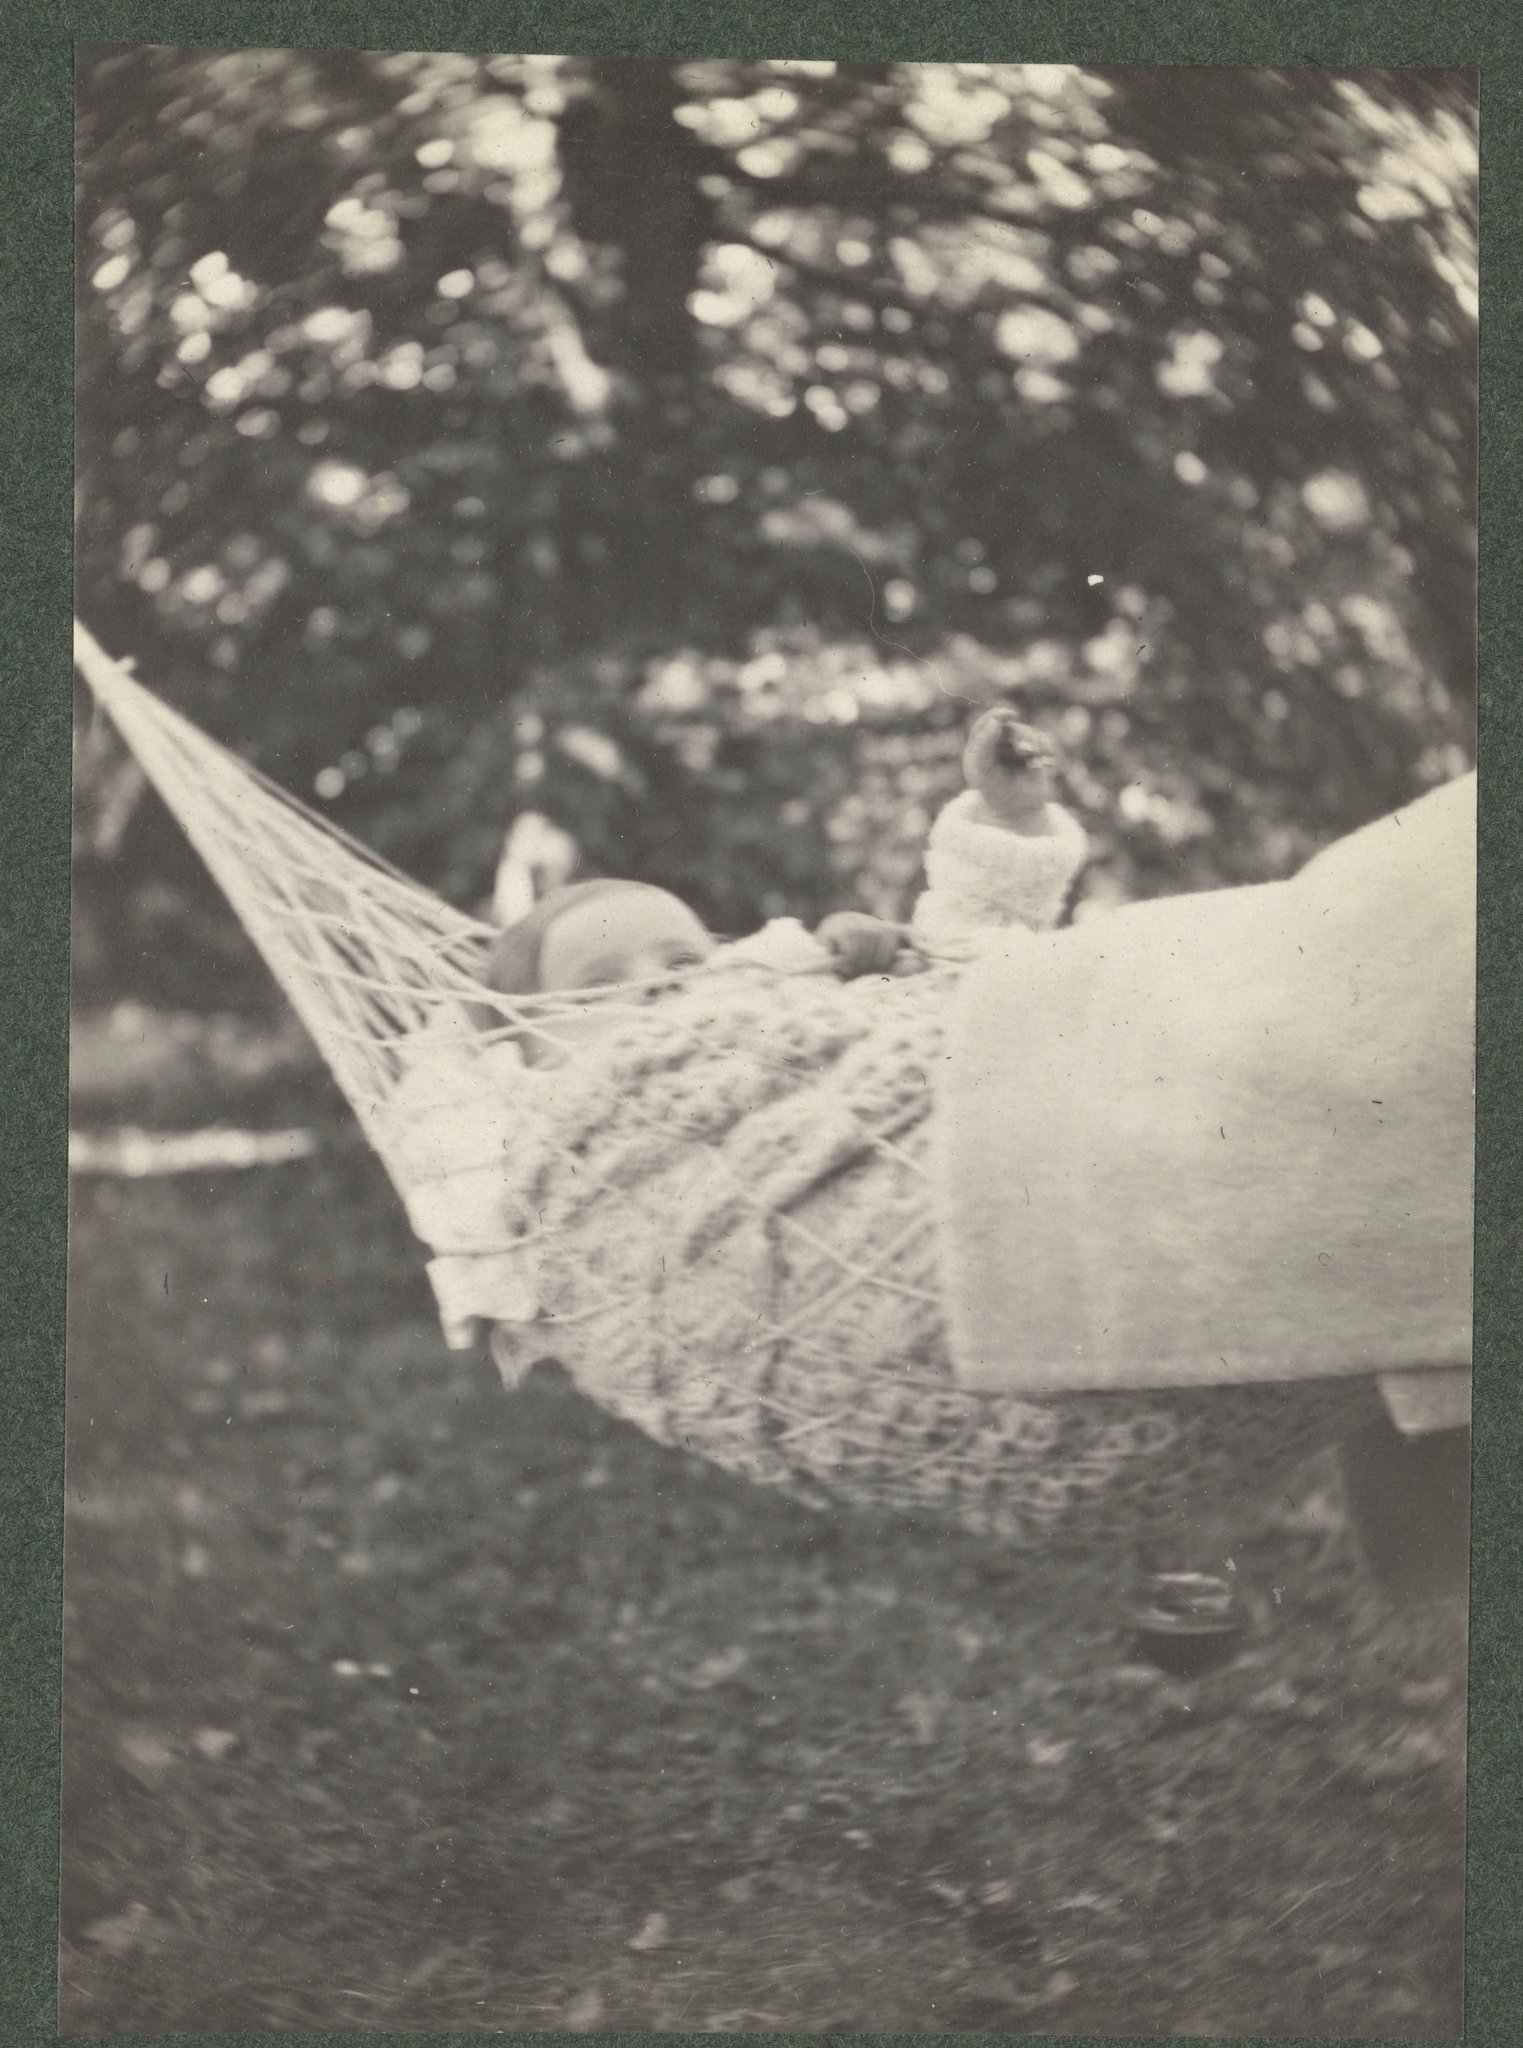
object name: photograph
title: Baby in een hangmat gewikkeld in een deken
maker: geldolph adriaan kessler (dolph)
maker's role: fotograaf, industrieel, voetballer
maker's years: 1884-1945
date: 1913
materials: paper, photographic support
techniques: photography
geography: netherlands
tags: huize de paauw